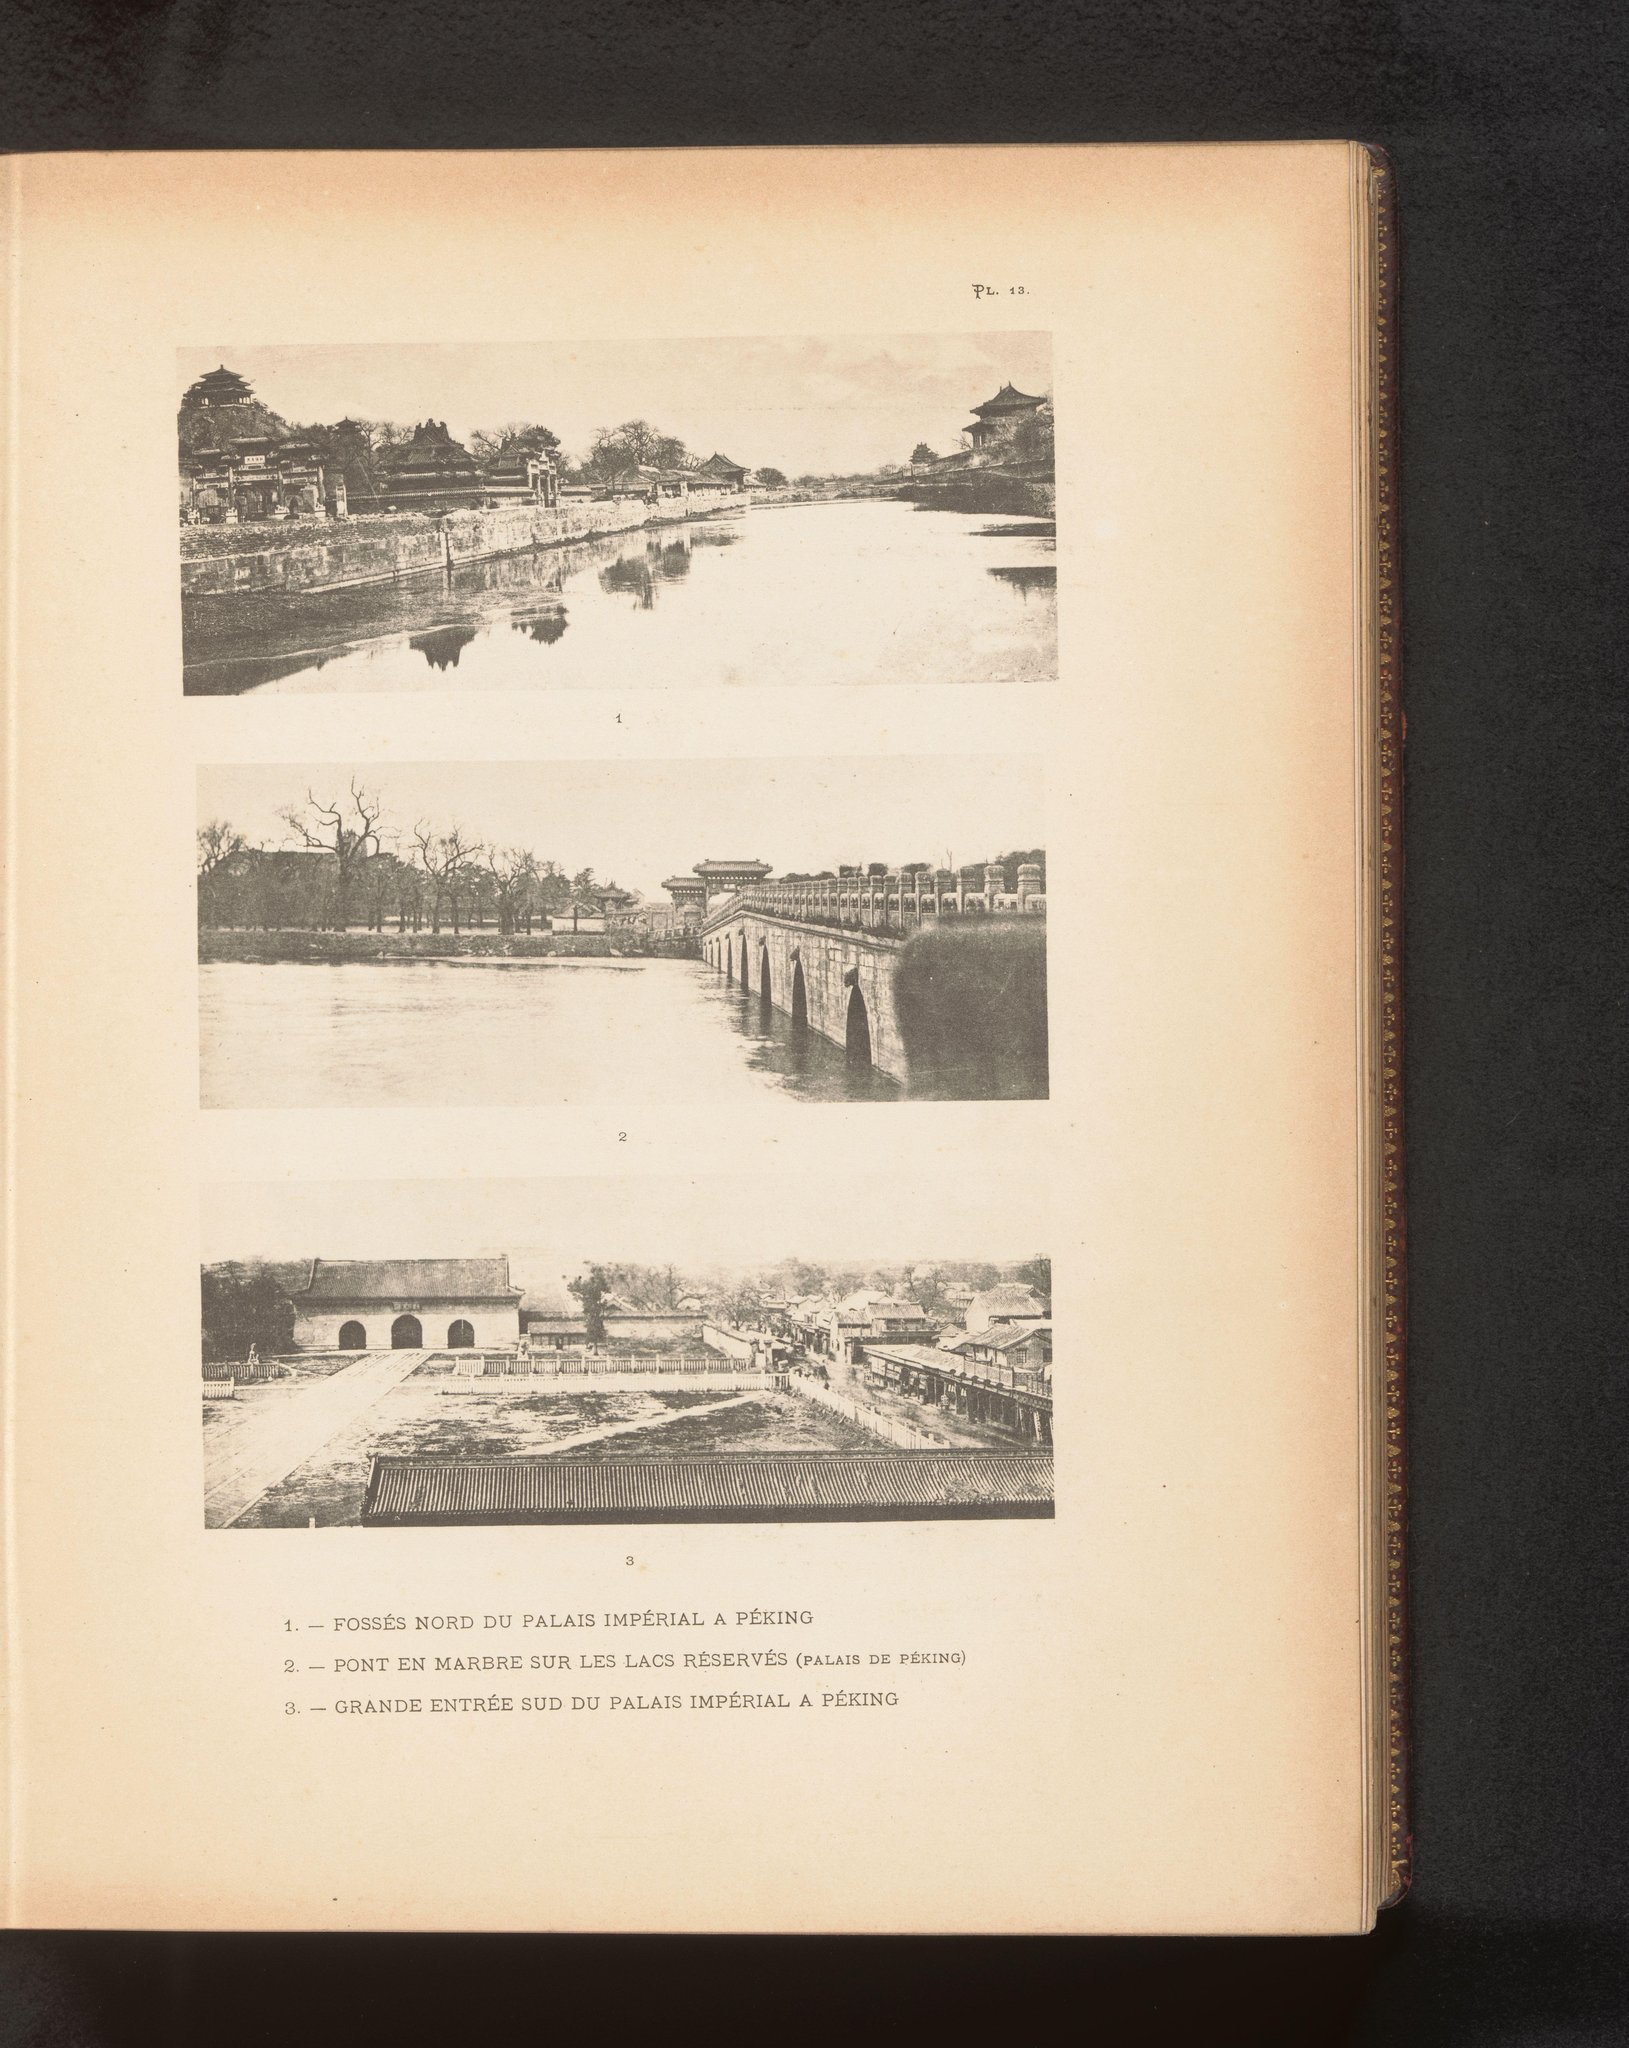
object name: photomechanical print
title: Grande entrée sud du palais impérial a péking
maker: Anonymous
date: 1892-1897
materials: paper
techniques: photograph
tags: palace, canals, waters (in city)